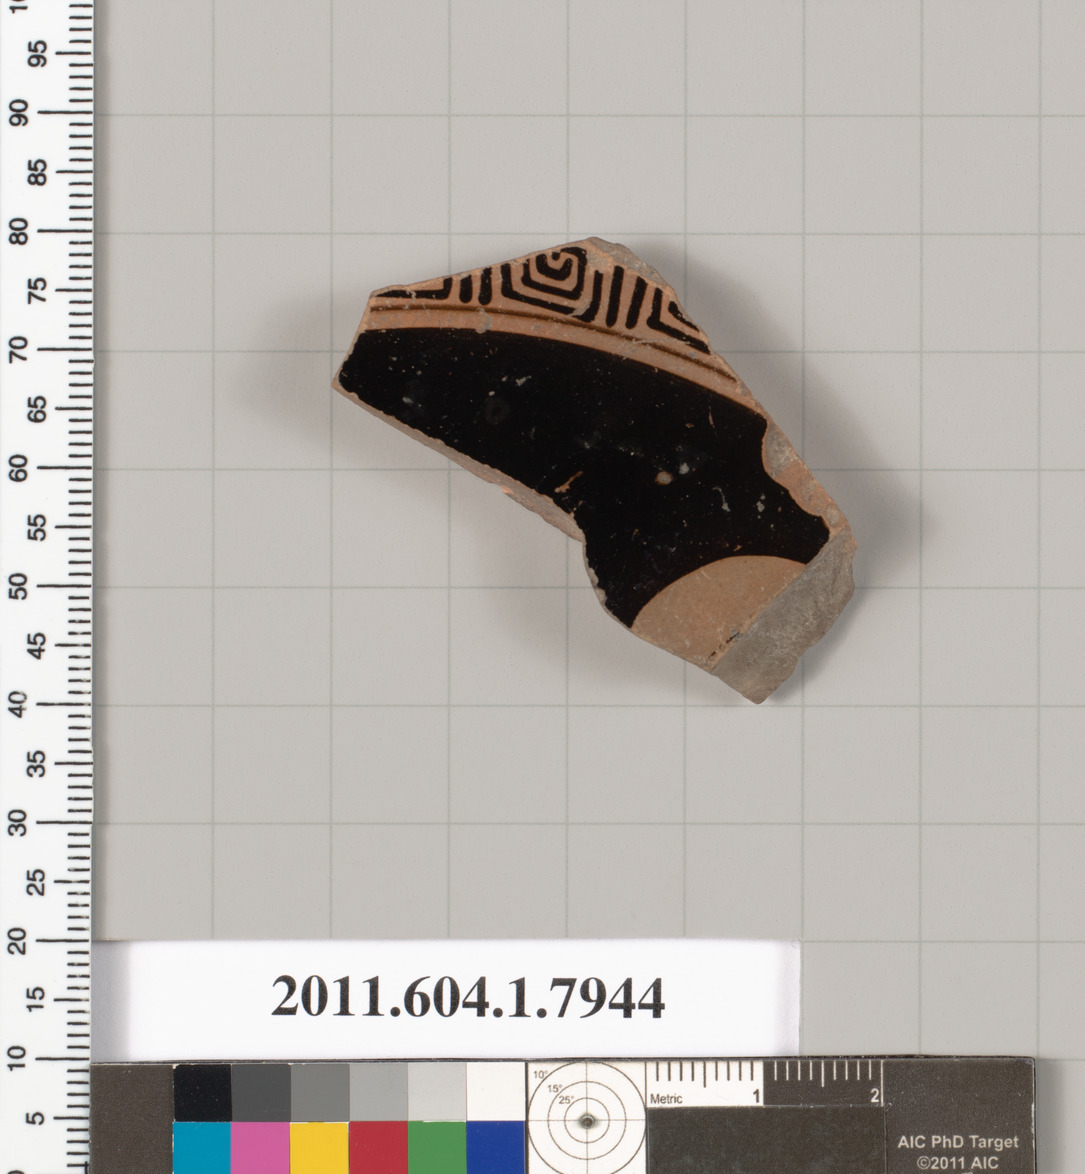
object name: kylix fragment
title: Terracotta fragment of a kylix (drinking cup)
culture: greek, attic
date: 460-450 BCE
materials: terracotta